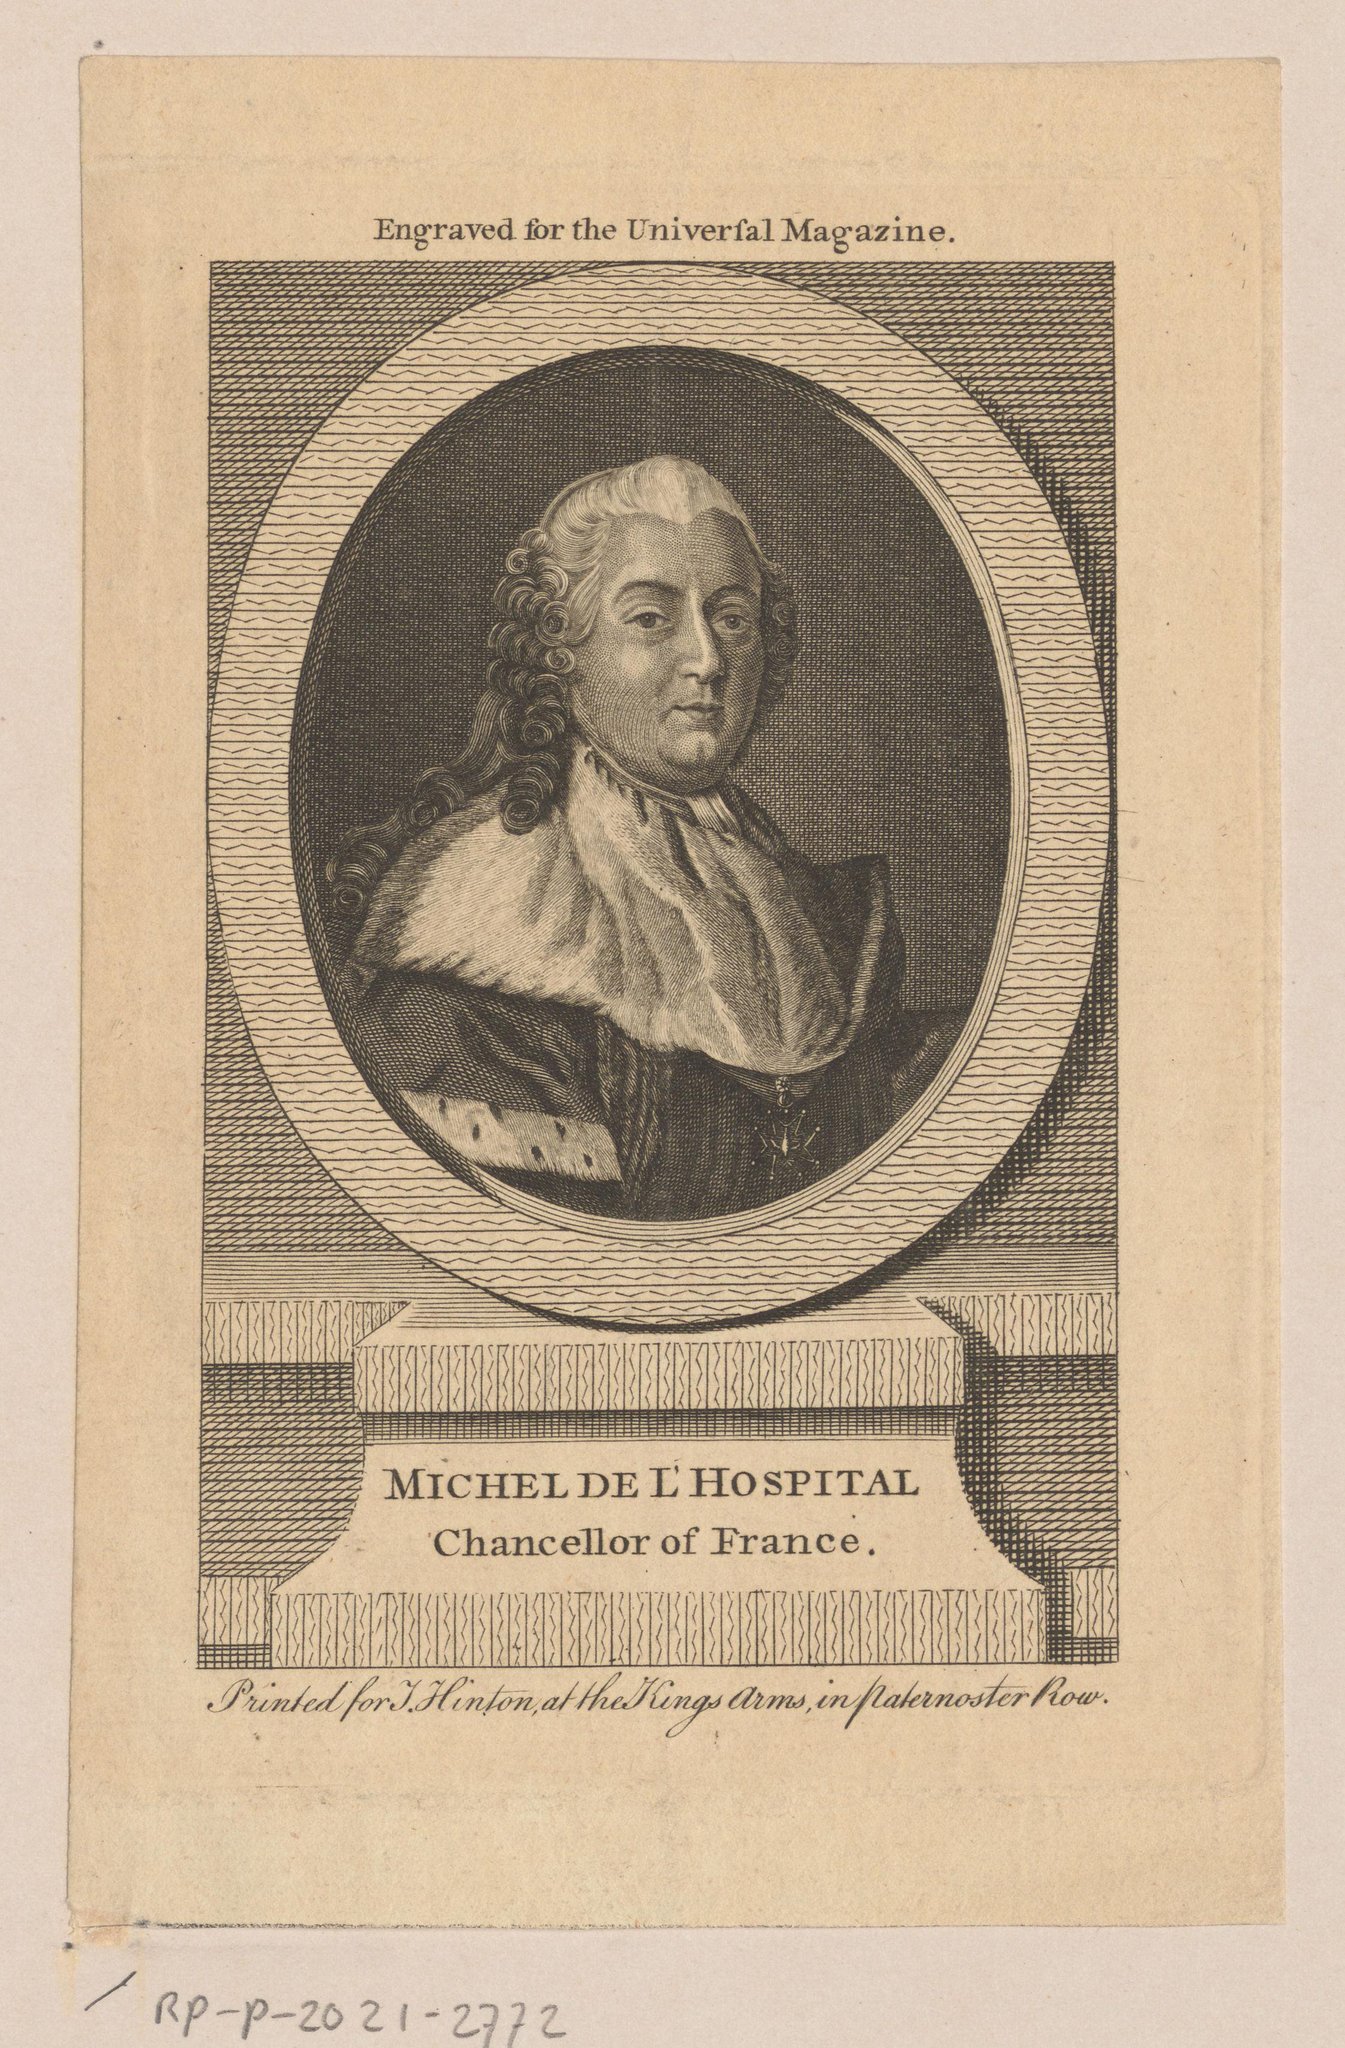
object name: print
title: Portret van zogenaamd Michel de L'Hospital, mogelijk Paul-François Galluccio de L'Hôpital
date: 1747-1781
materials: paper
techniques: engraving, etching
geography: england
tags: ornament ~ medallion, historical persons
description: Prent komt uit een editie van The Universal Magazine.